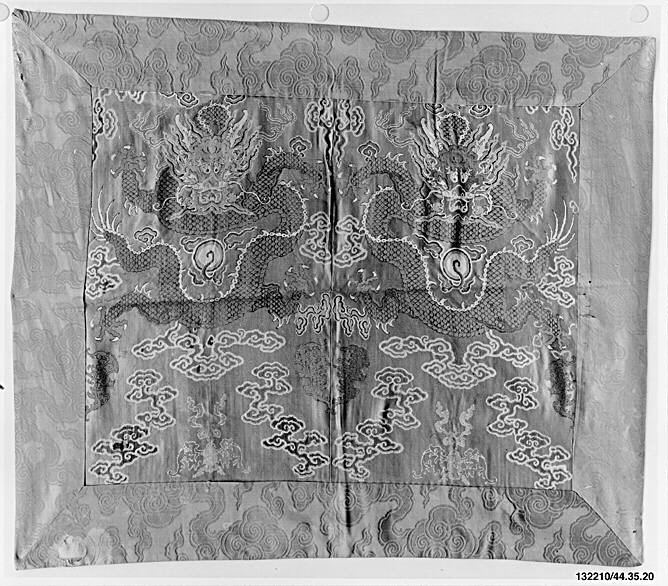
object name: panel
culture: chinese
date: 1701-1733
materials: cotton, metal thread, silk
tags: dragons